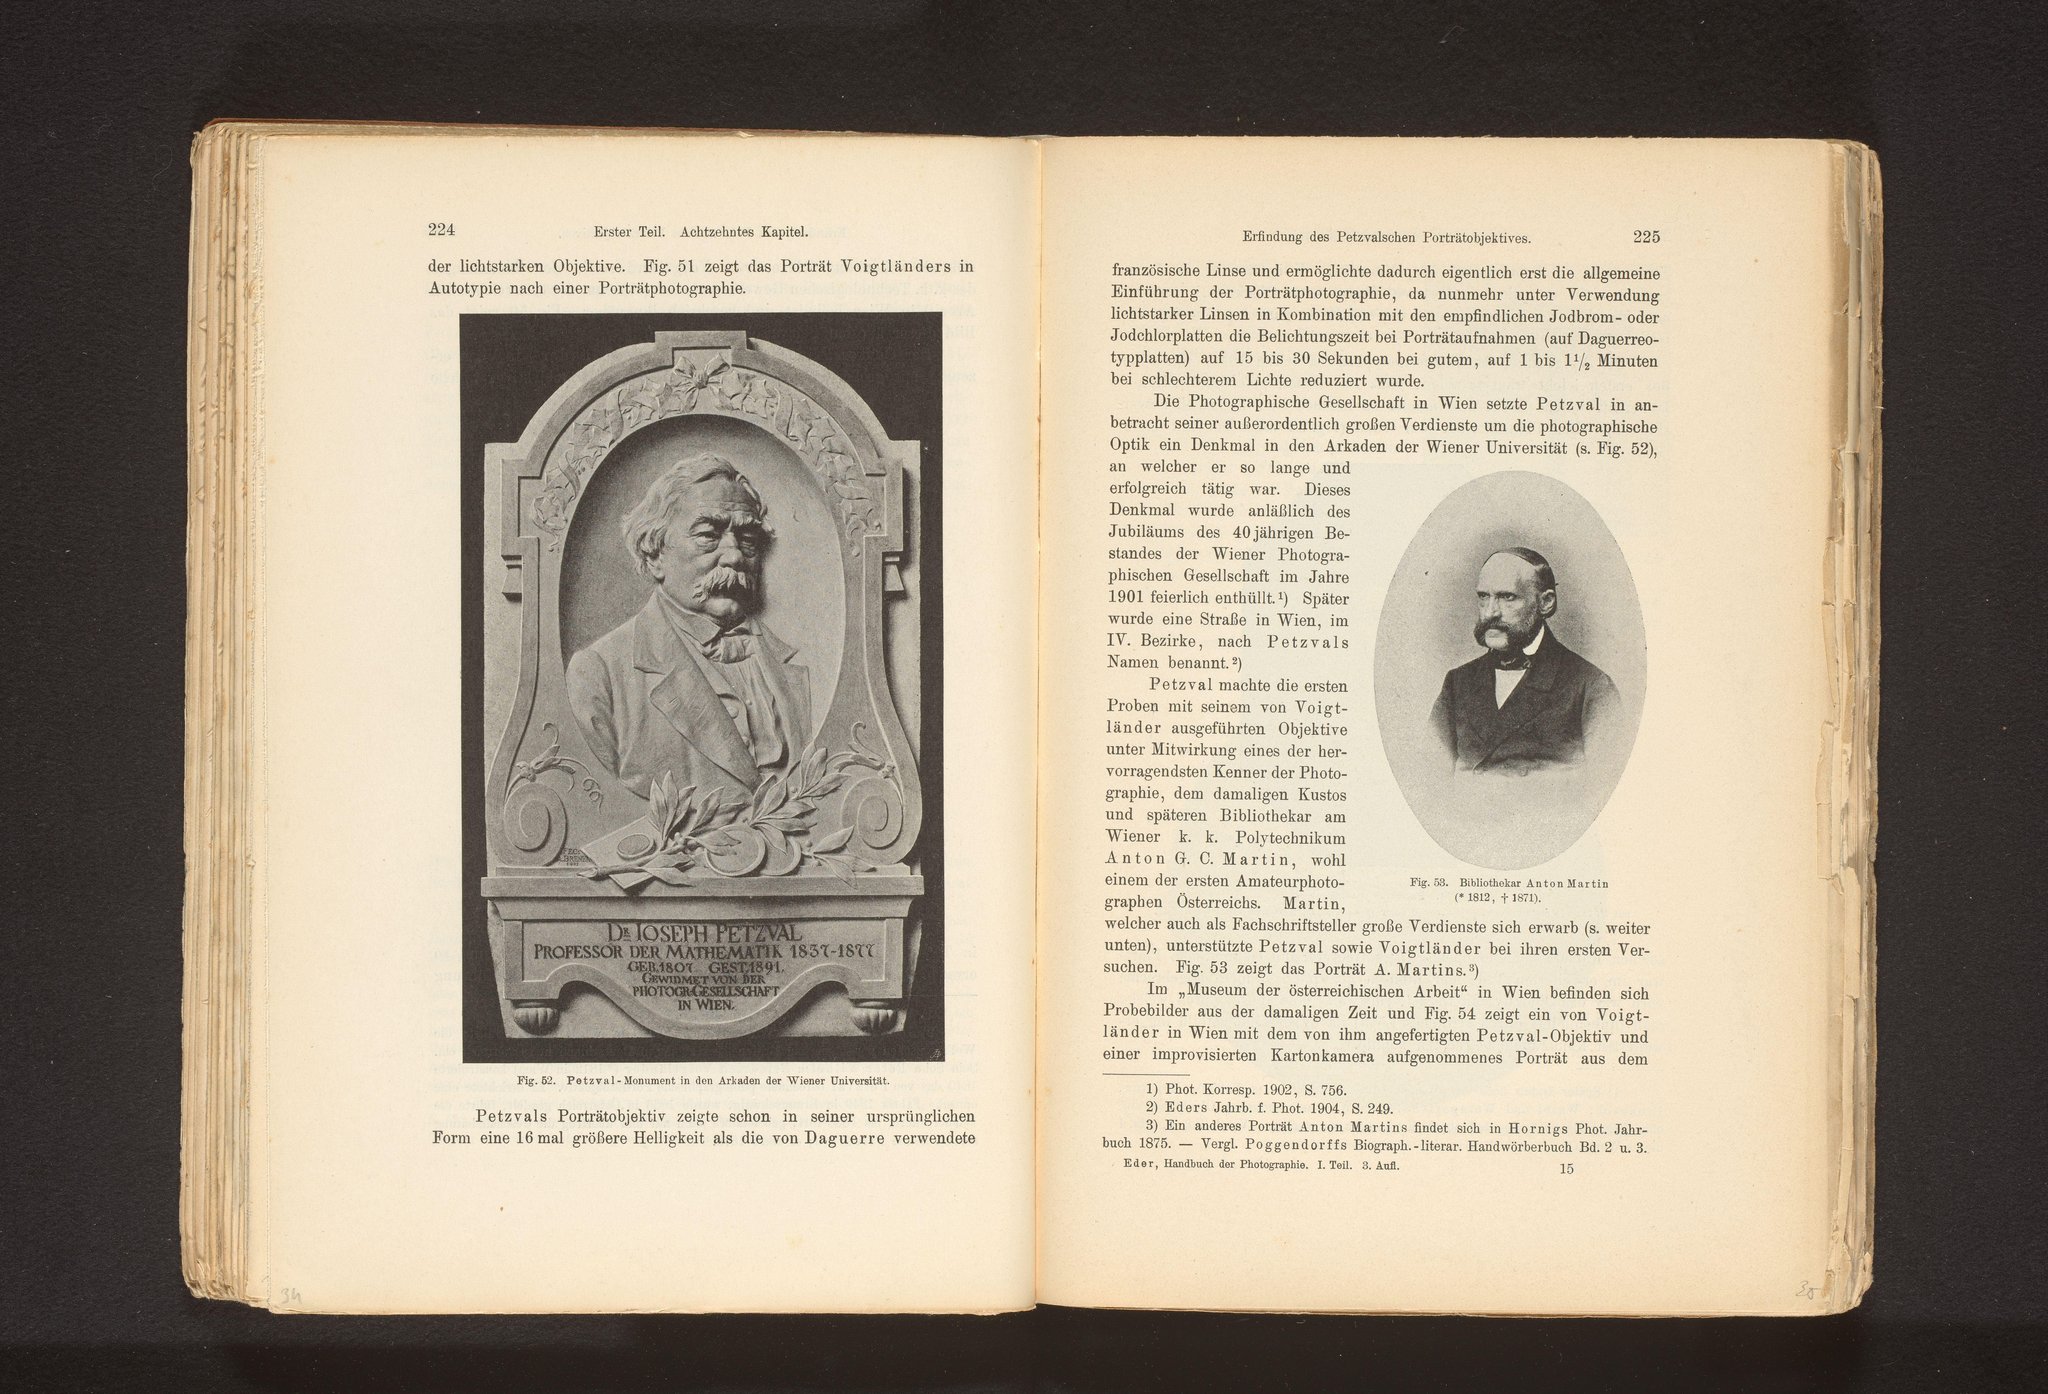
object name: page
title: Monument voor Joseph Petzval in de Universiteit van Wenen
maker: Anonymous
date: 1900-1905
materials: paper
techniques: autotype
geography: vienna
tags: monument, statue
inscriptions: number: ‘Fig. 52.’